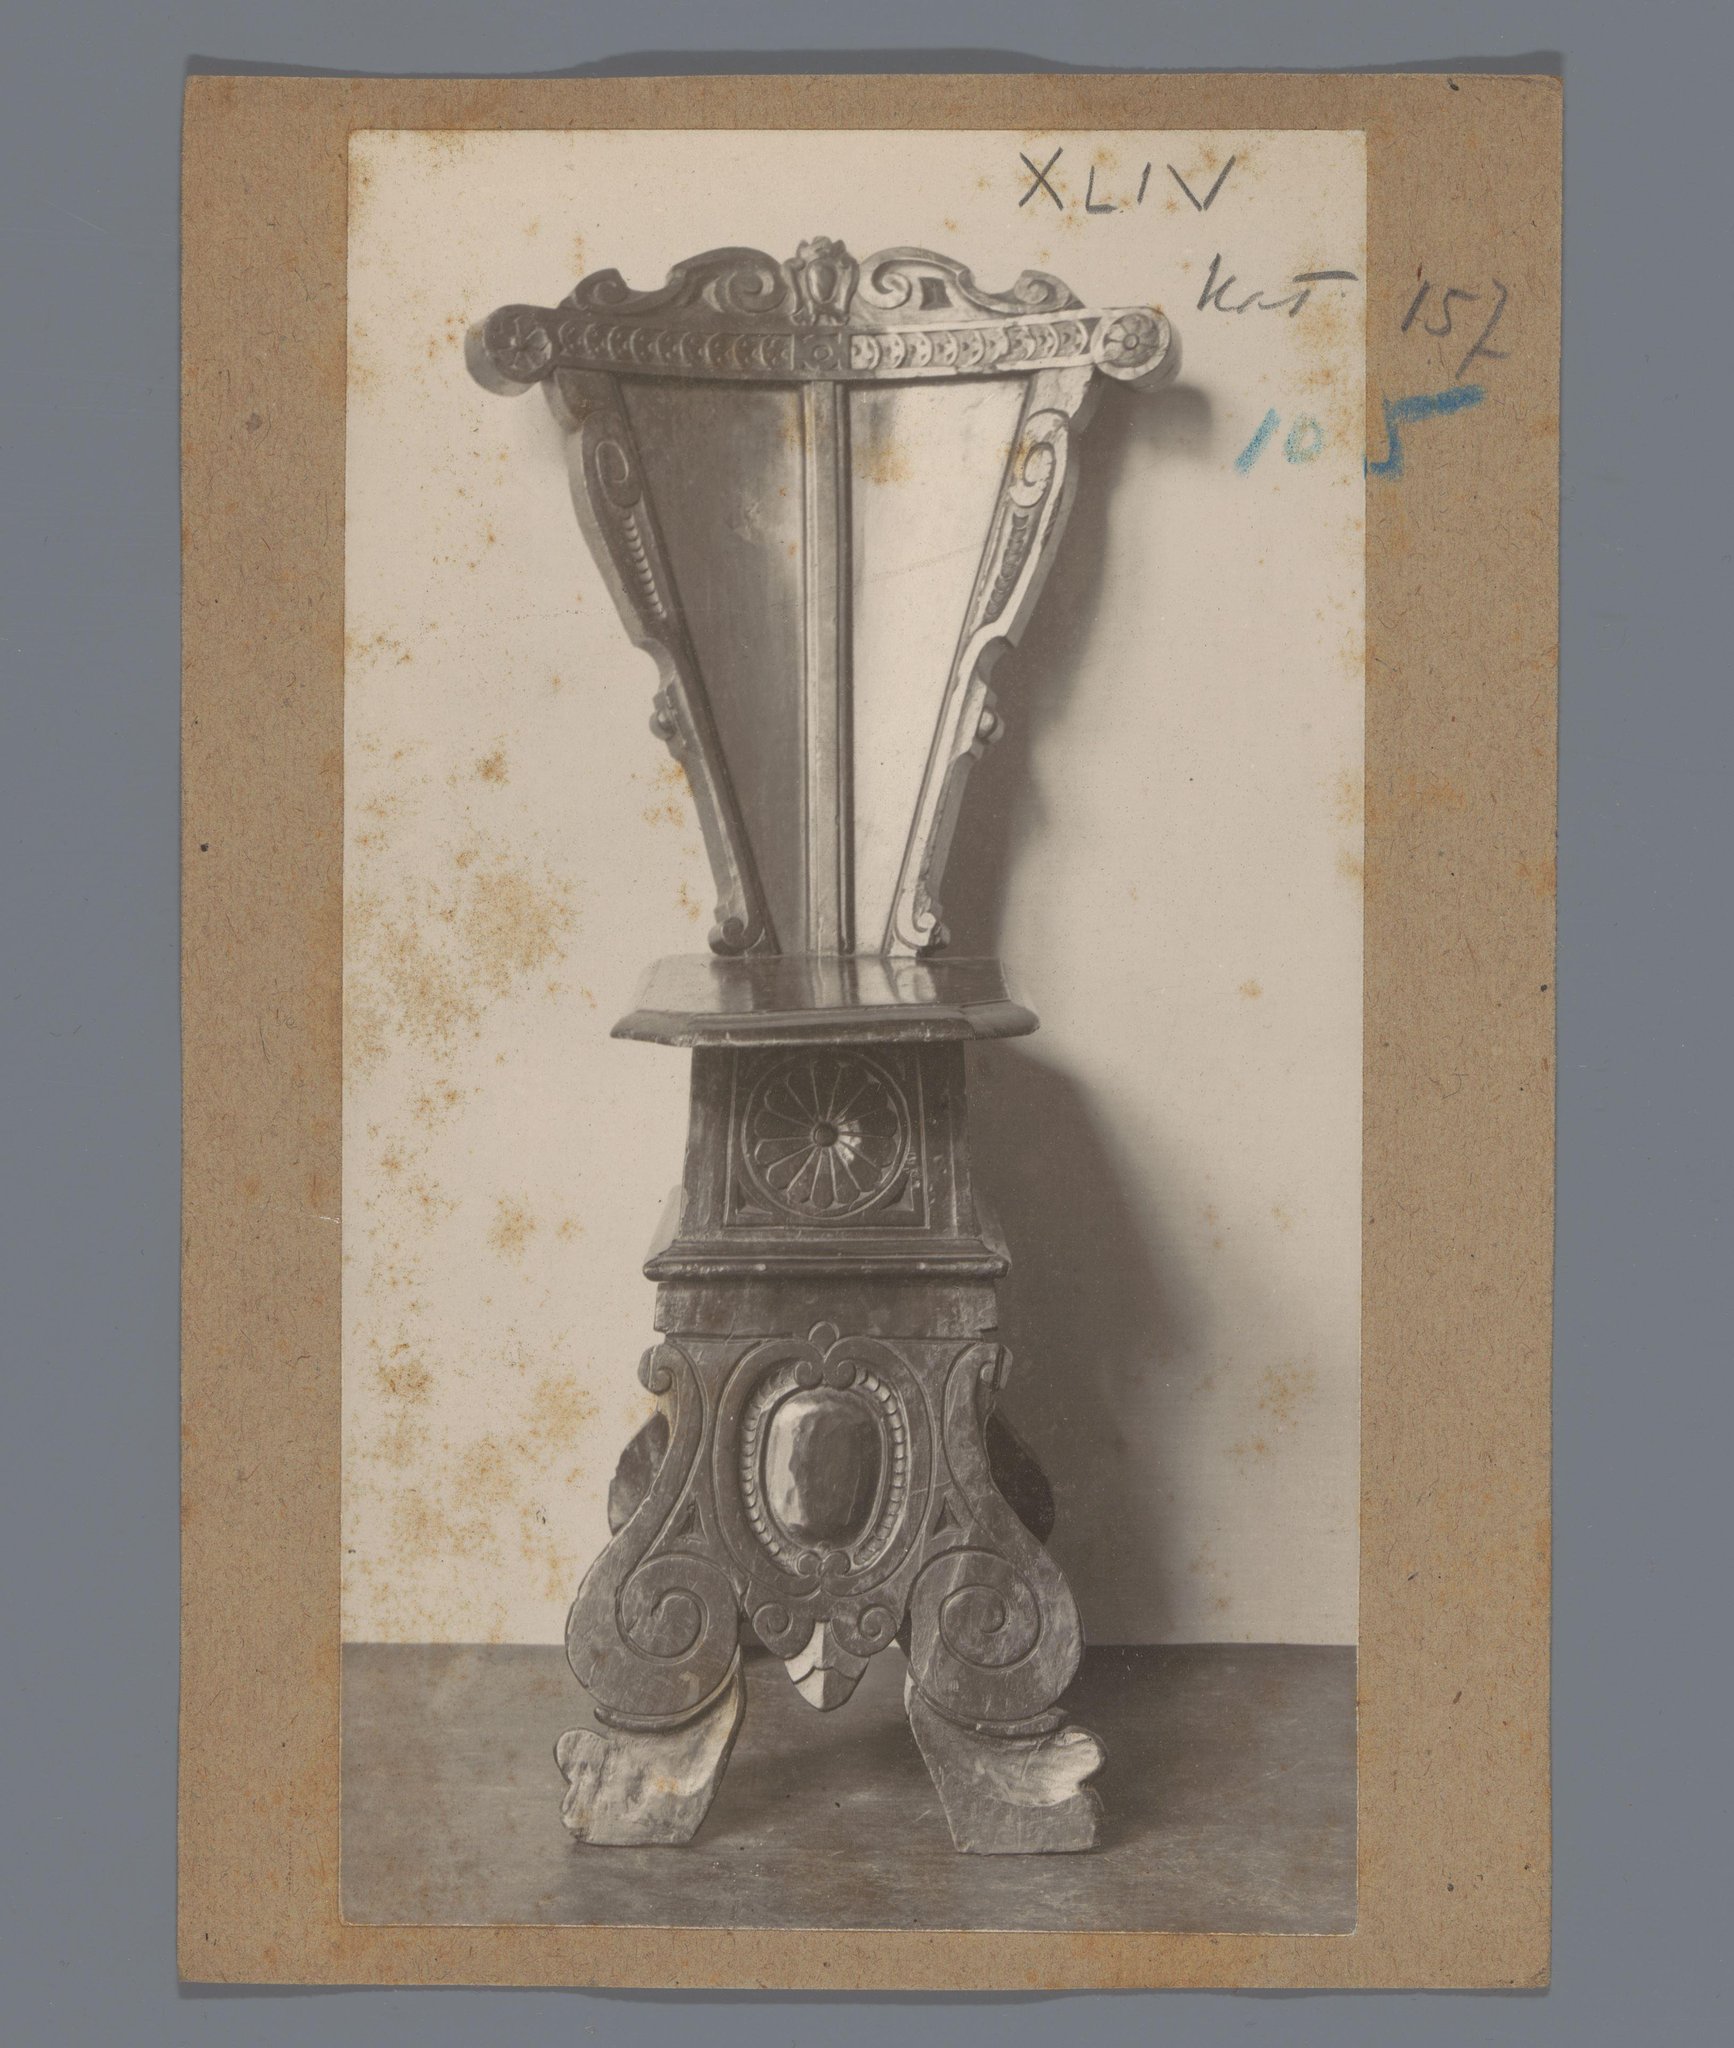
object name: photograph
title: Sgabello gedecoreerd met voluten, rozetten en een cartouche in het Rijksmuseum te Amsterdam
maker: Anonymous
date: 1875-1900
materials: photographic support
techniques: matte daylight collodion silver print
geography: amsterdam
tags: chair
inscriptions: number: ‘XLIV kat 157 105’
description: Zie voor het originele object BK-NM-11948.